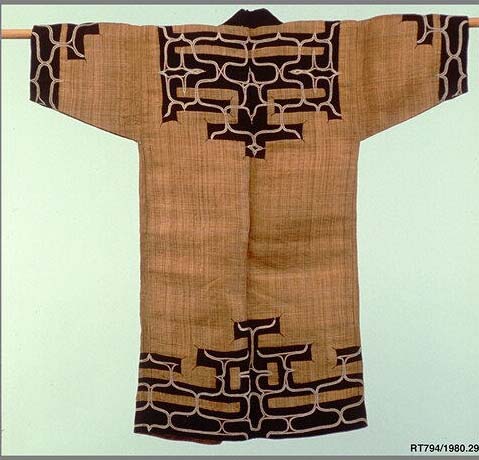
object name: robe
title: Ainu Robe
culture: japanese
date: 1801-1900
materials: wood, fiber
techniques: appliqué, dyeing